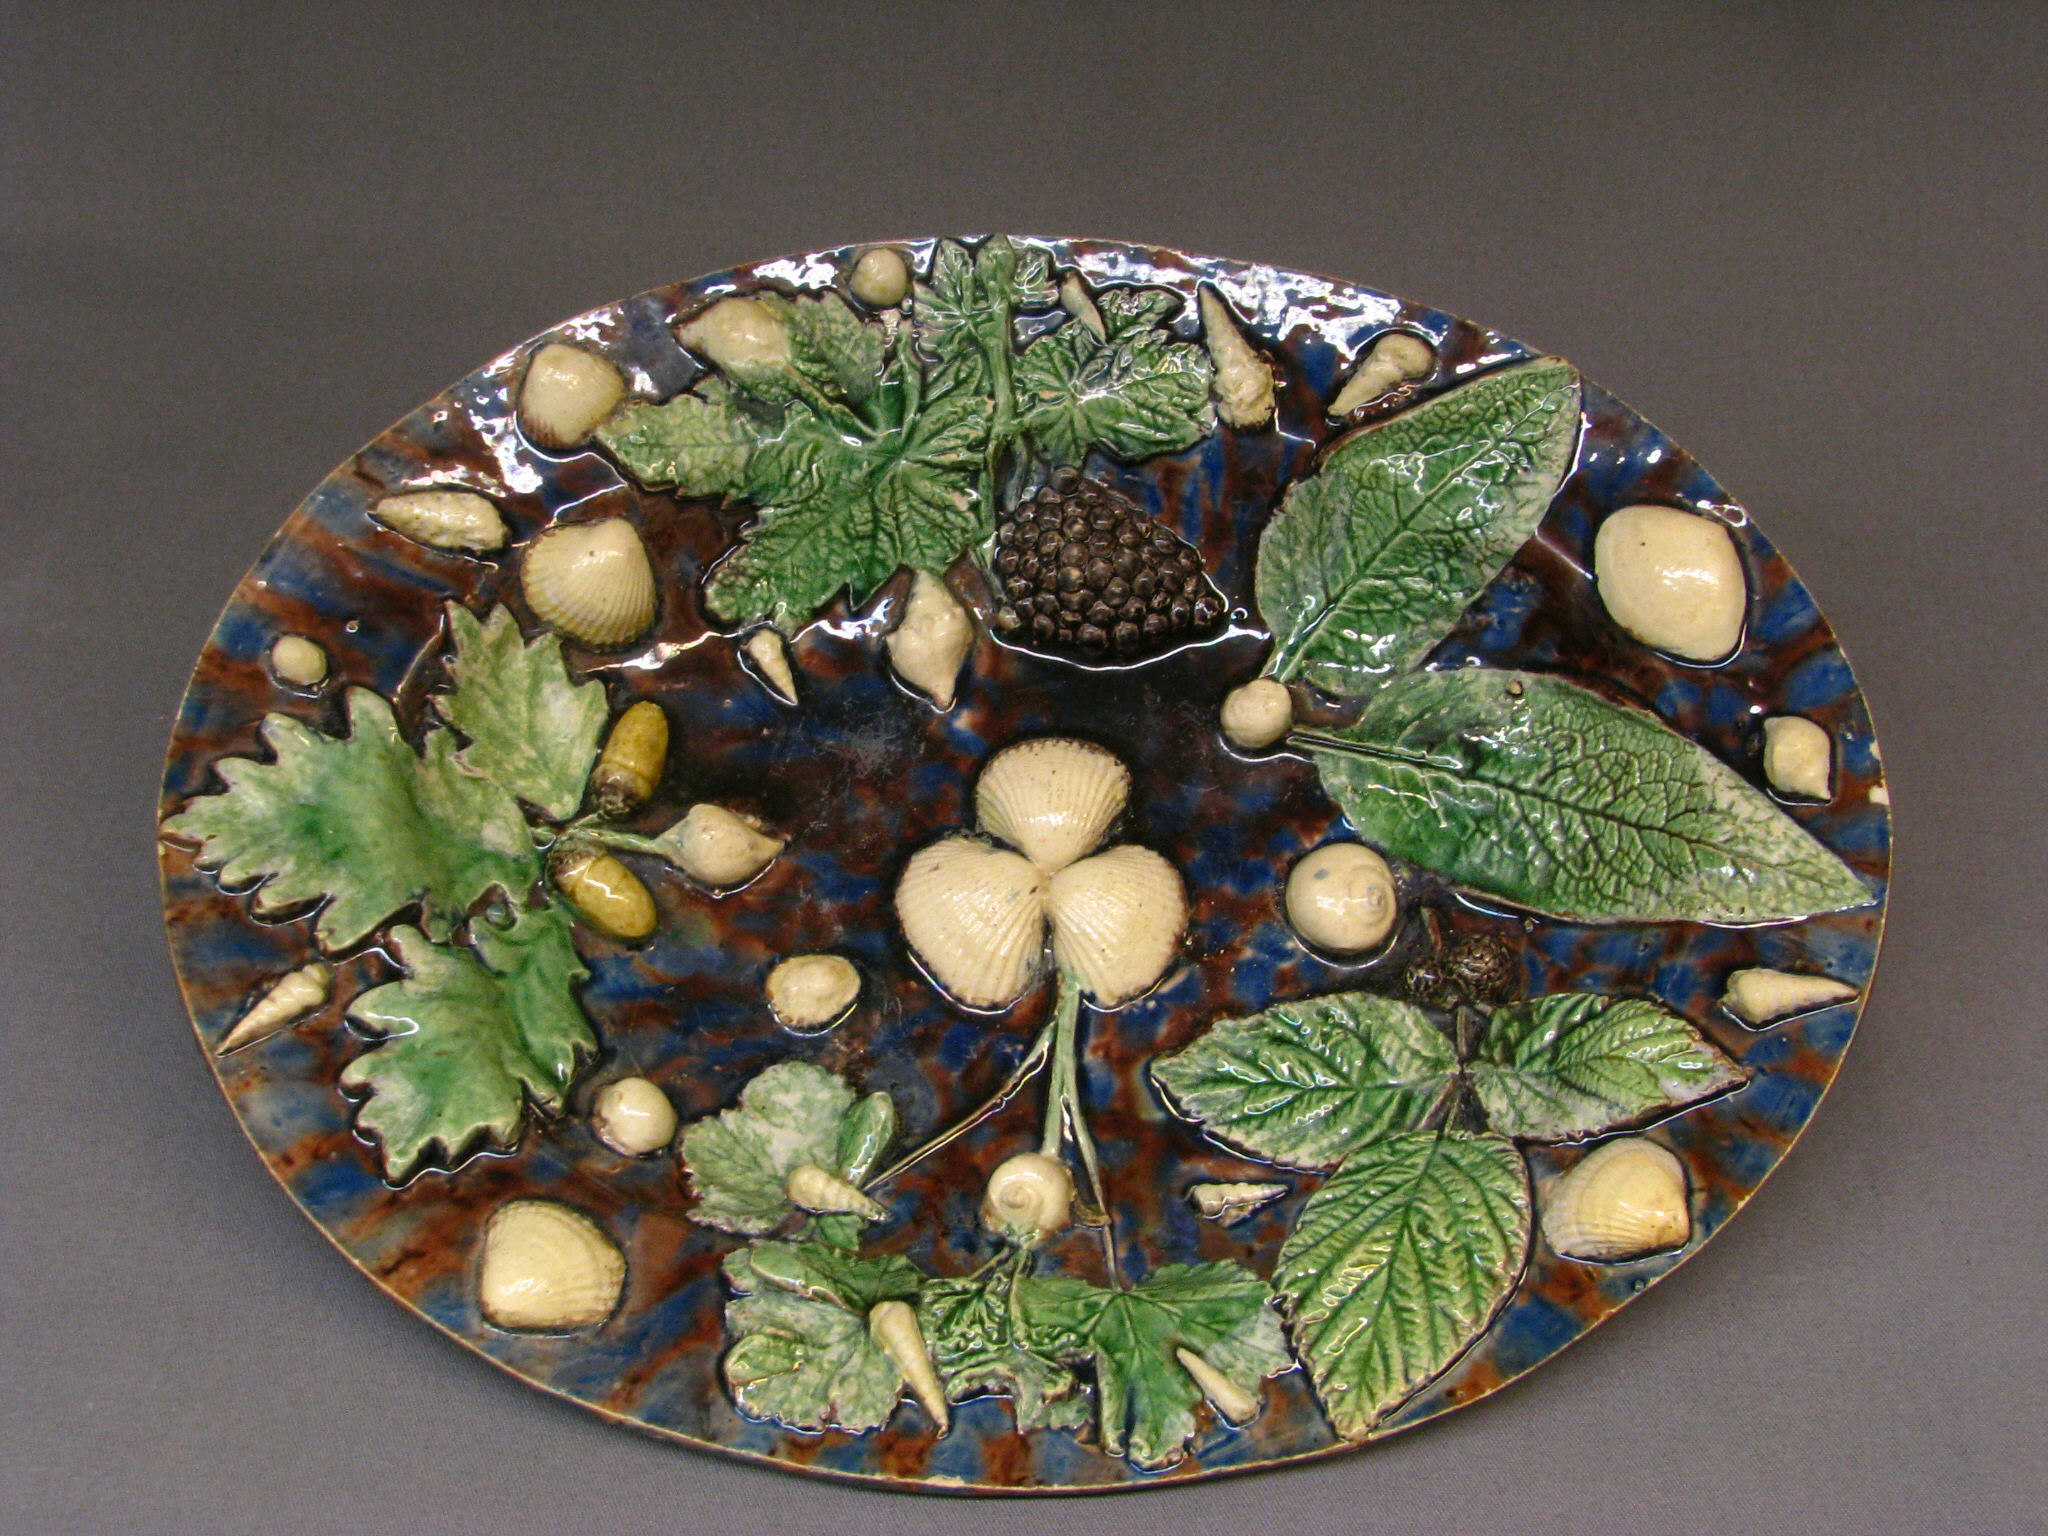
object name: dish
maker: bernard palissy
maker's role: maker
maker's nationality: french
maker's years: 1510-1590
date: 1551-1600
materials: earthenware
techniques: glazing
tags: shells